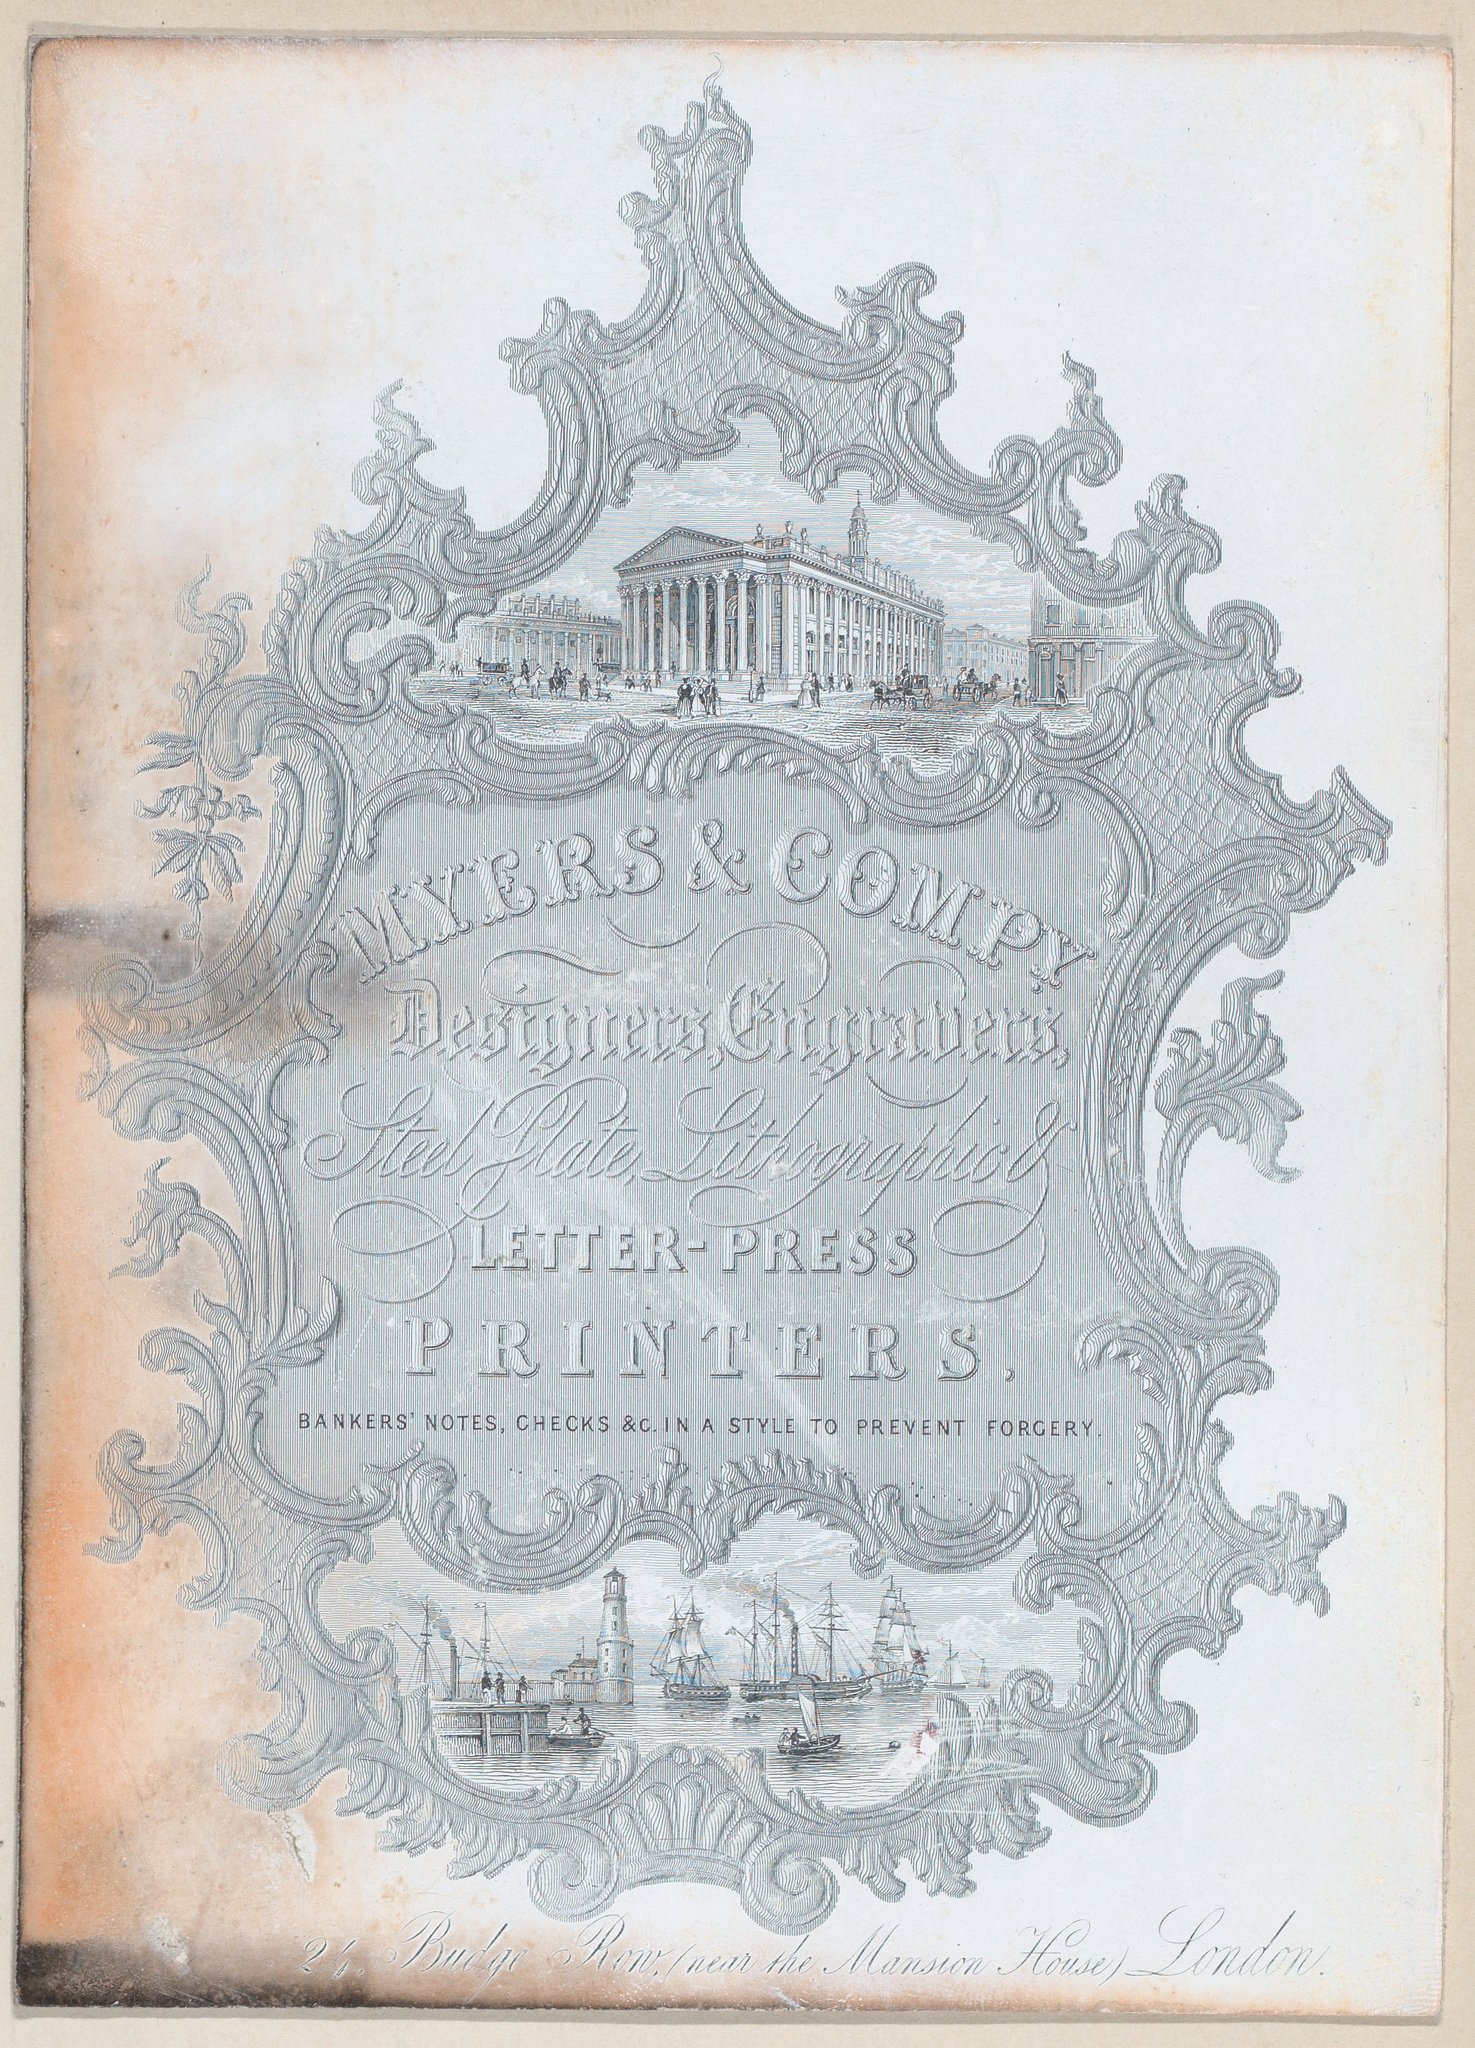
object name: print, trade card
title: Trade Card for Myers & Co., Designers, Engravers, Steel Plate, Lithographic & Letterpress Printers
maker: anonymous, british, 19th century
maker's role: artist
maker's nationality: british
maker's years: 1800-1900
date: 1801-1900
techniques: lithography